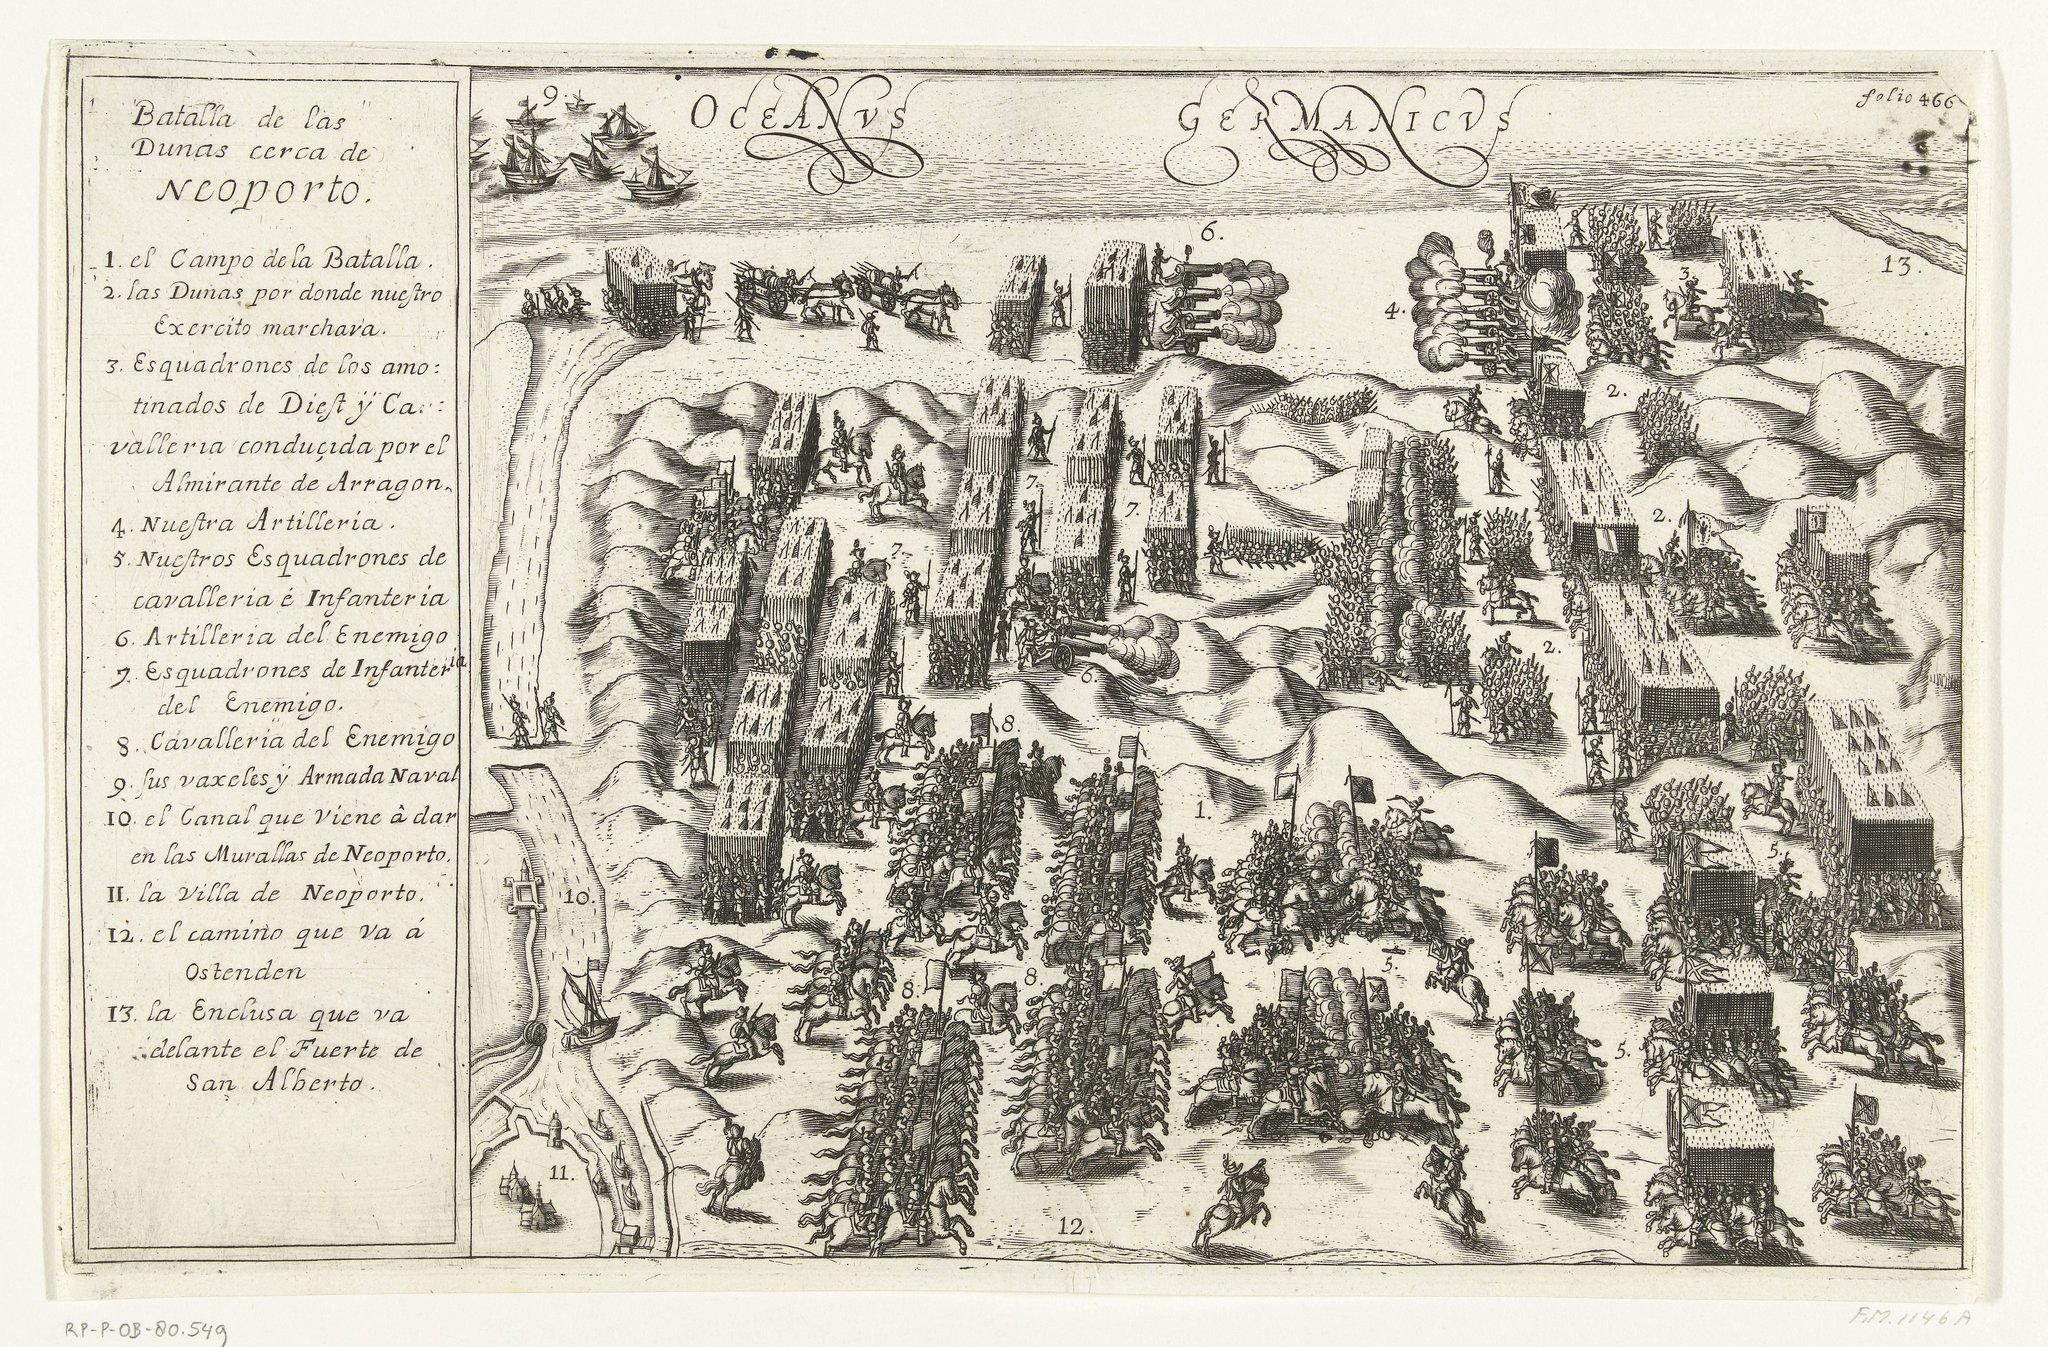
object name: print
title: Batalla de las Dunas cerca de Neoporto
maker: Anonymous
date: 1600-1624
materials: paper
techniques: engraving, etching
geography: italy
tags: the hague, maurice (prince of orange), brussels, albrecht aartshertog van oostenrijk, battle (+ land forces), battle of nieuwpoort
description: De slag bij Nieuwpoort, 2 juli 1600. Gevechten op het strand en in de duinen tussen het Staatse leger onder Maurits en de Spaanse troepen onder Albrecht. Links de legenda 1-13 in het Italiaans.